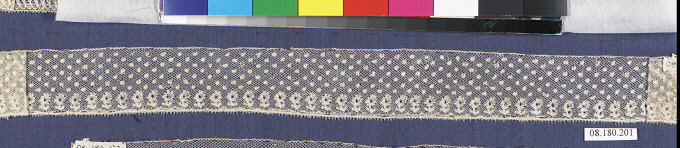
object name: fragment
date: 1701-1900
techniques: lace